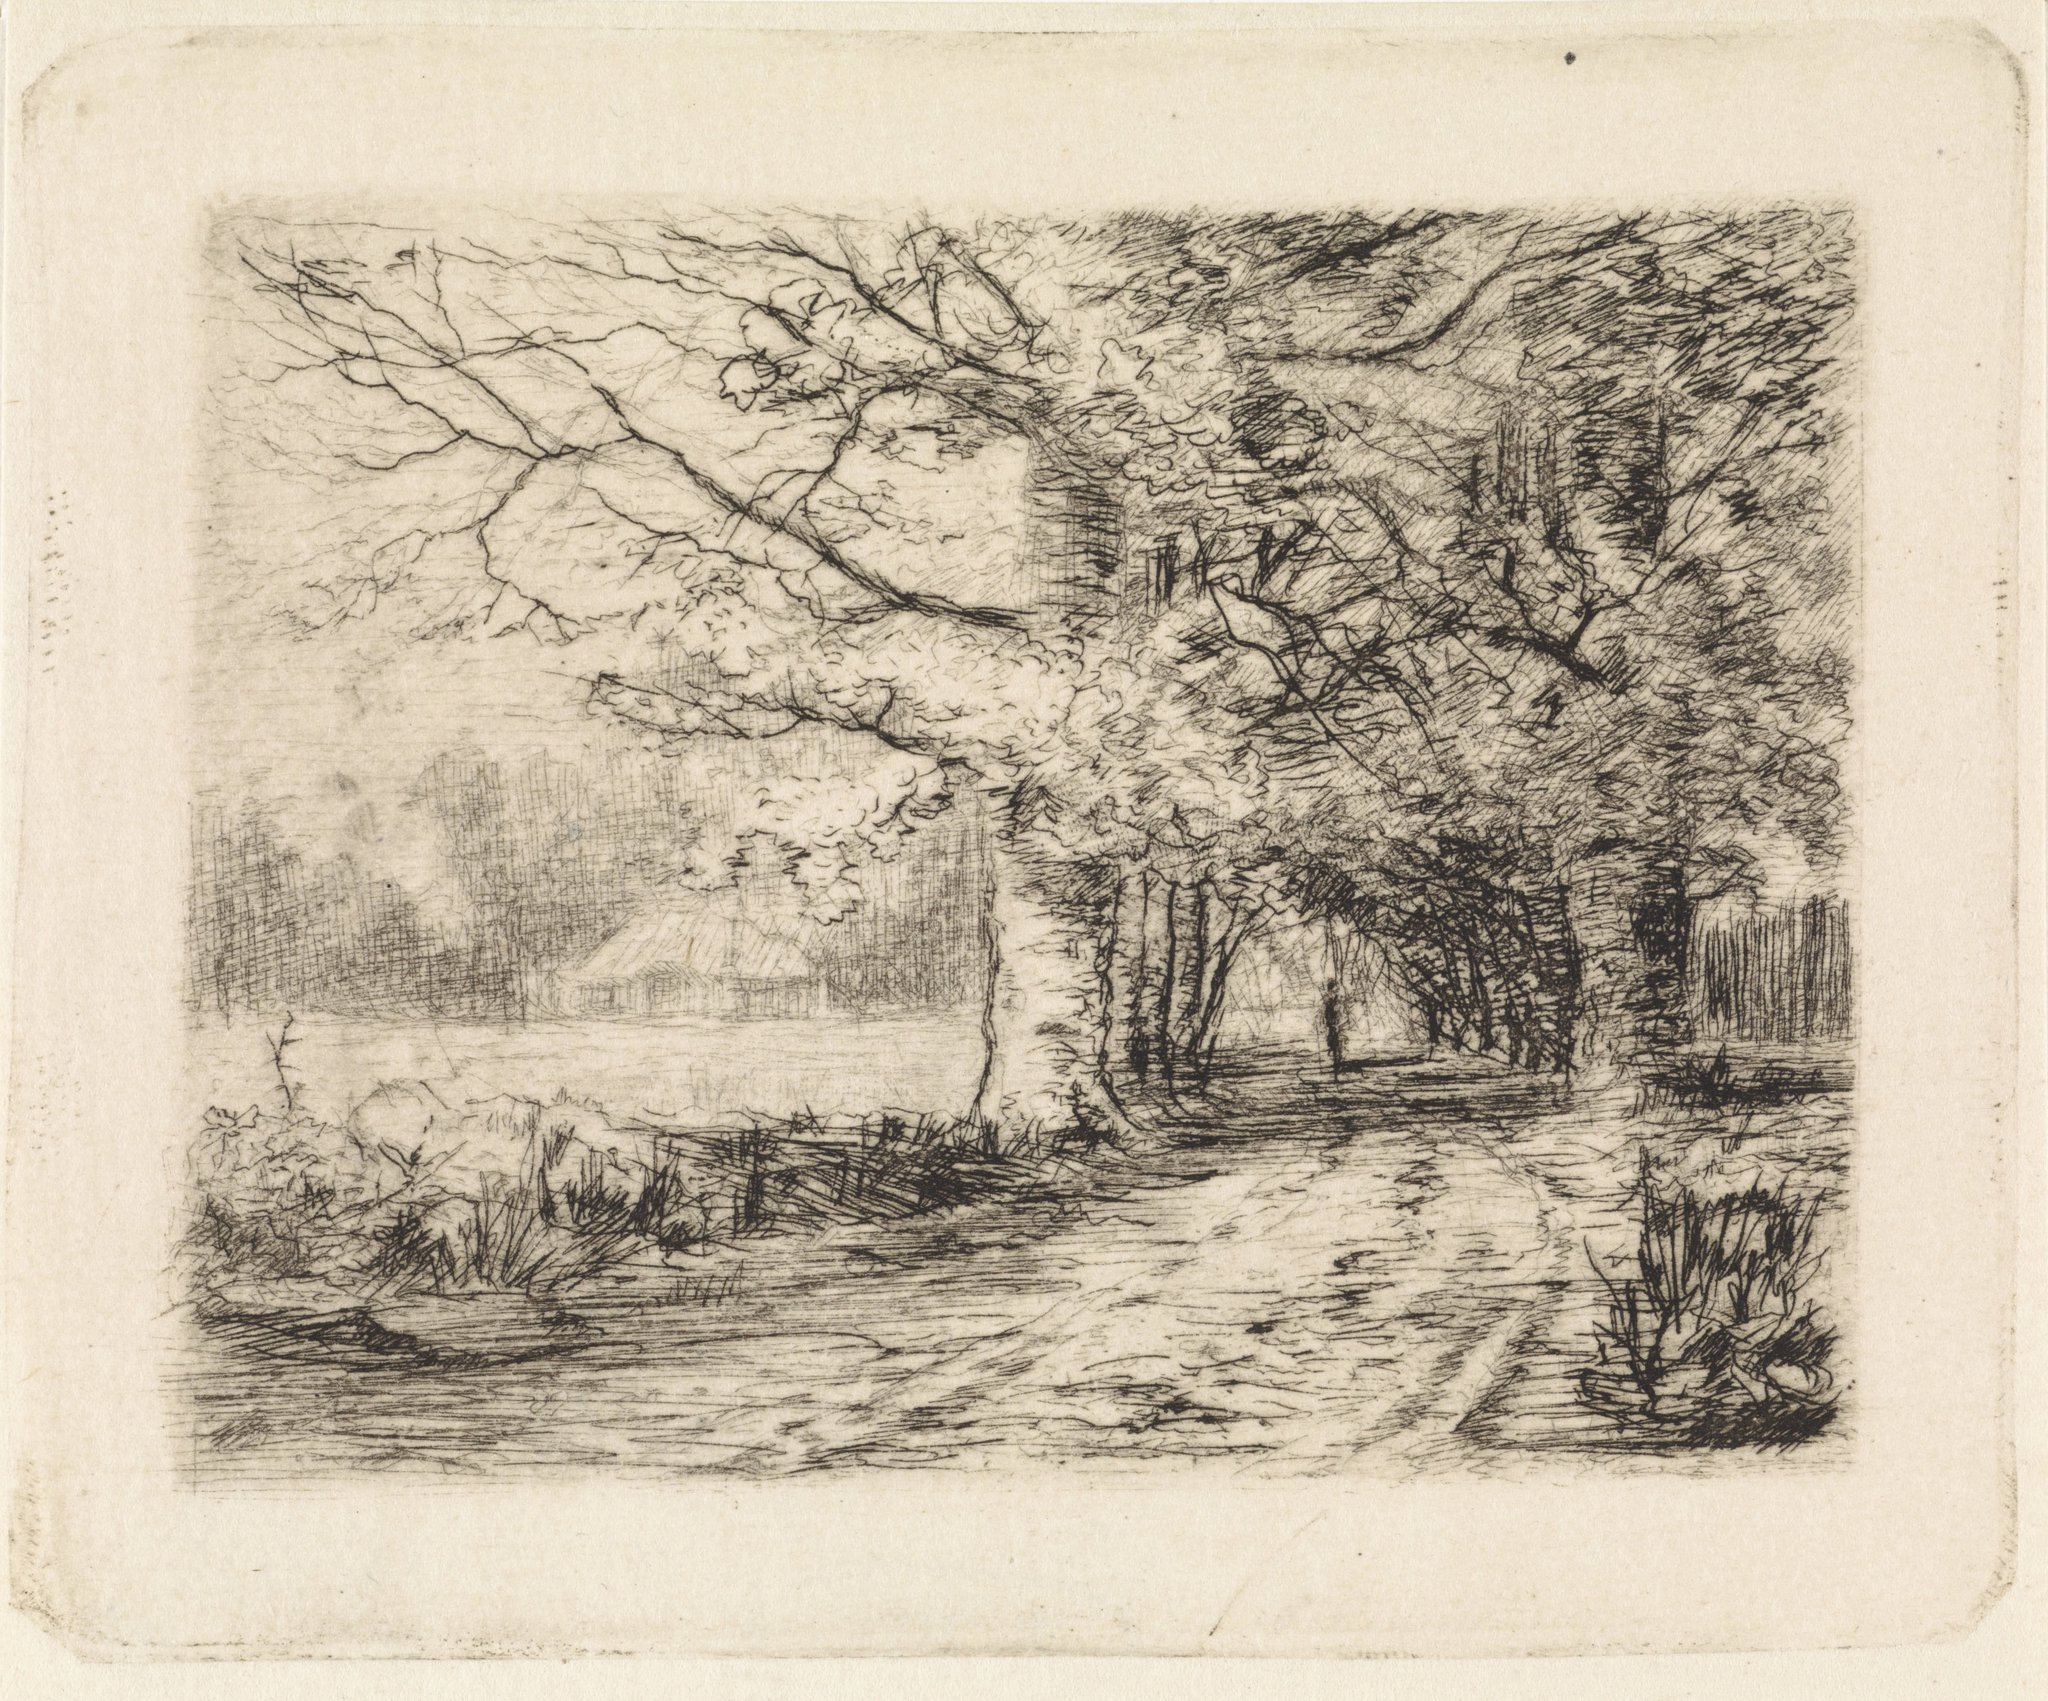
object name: print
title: Weg met bomen aan weerszijden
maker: elias stark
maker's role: draughtsman, print maker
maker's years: 1849-1933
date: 1859-1886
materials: paper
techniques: etching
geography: netherlands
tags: trees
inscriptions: collector's mark: Lugt 2228